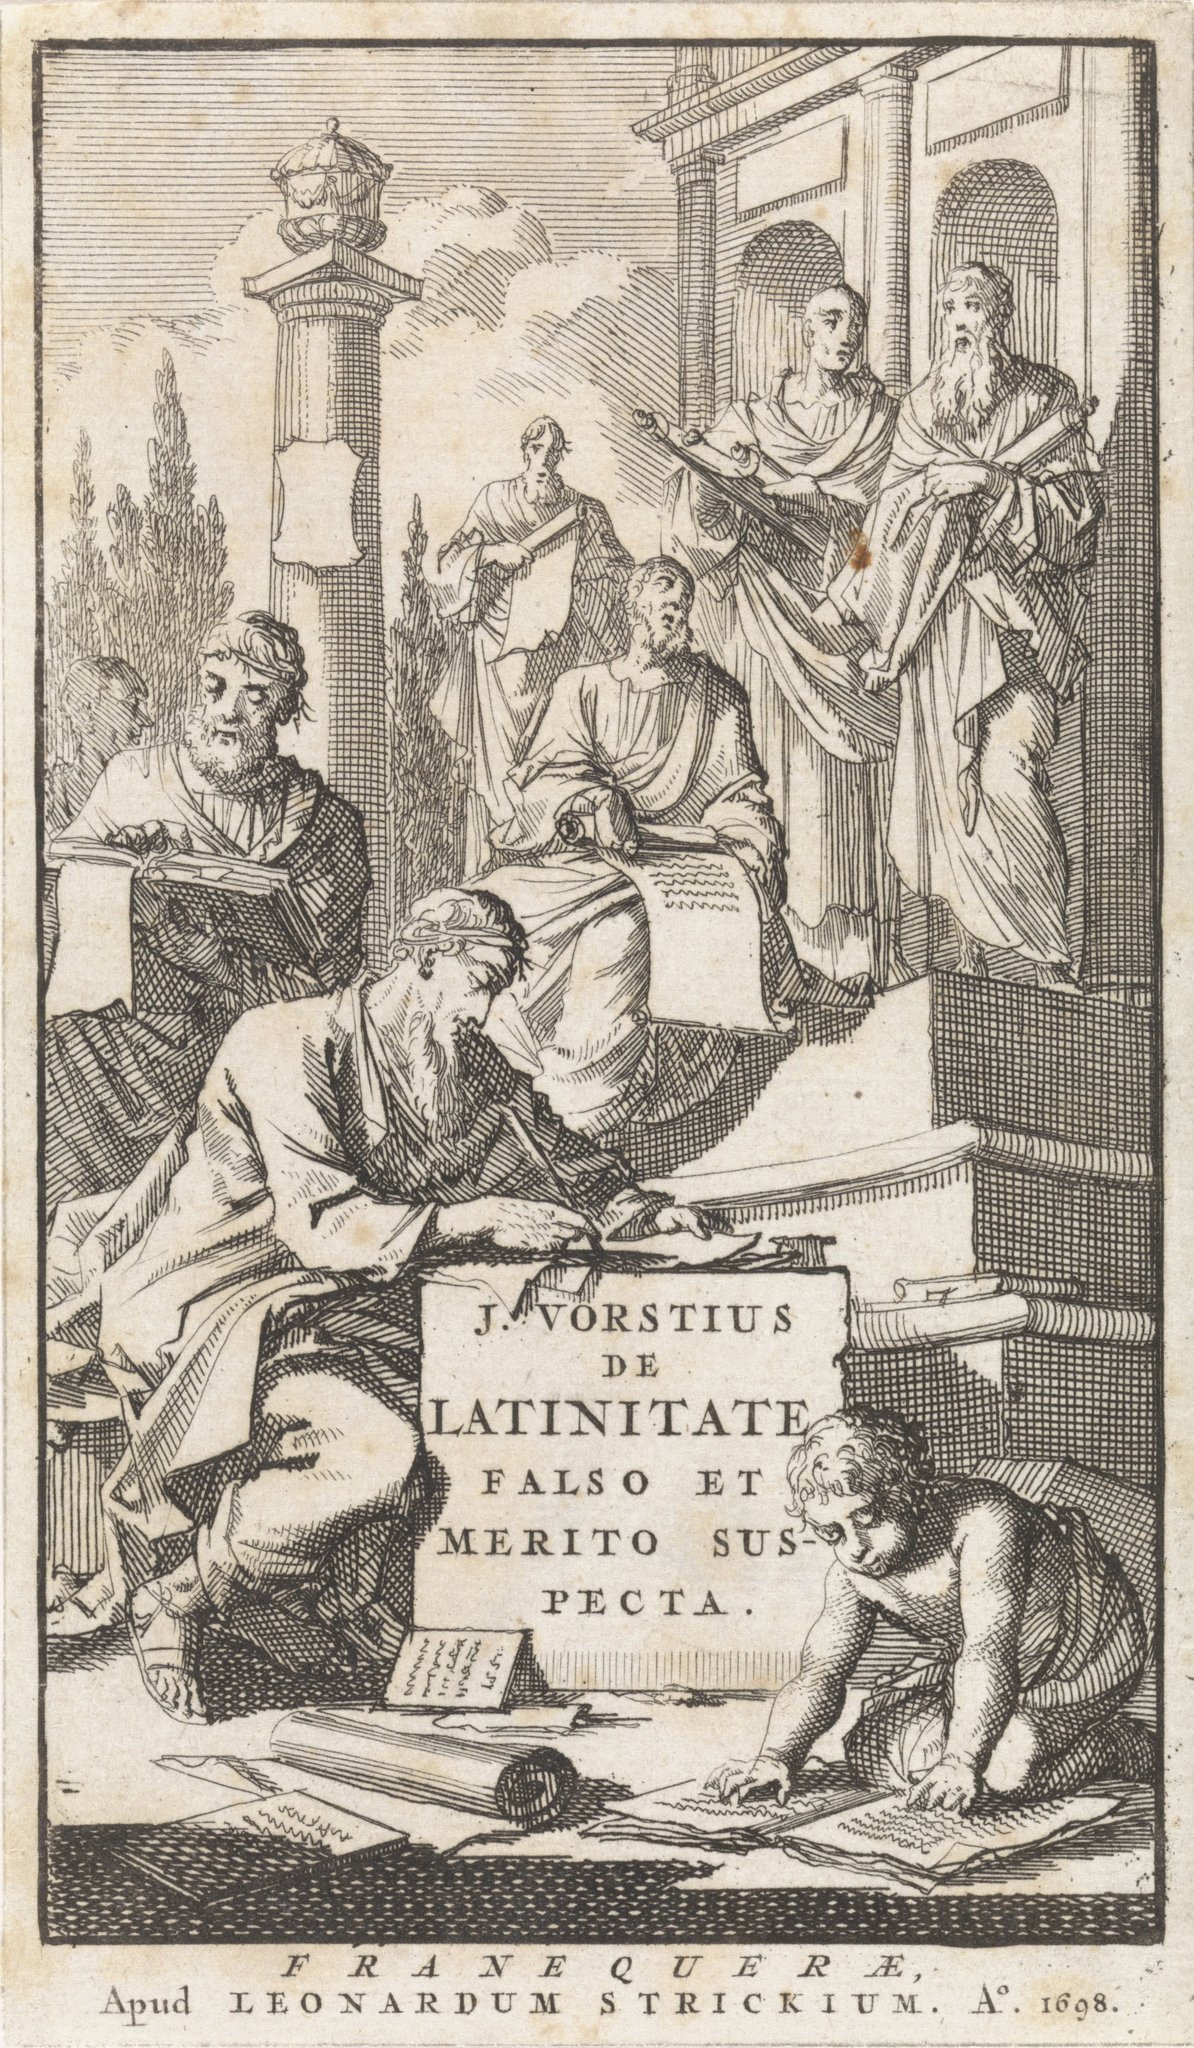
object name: print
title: Zes geleerden met rollen perkament op de trap van een tempel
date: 1698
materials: paper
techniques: etching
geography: franeker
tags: parchment, vellum (writing material), group of scholars or philosophers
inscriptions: collector's mark: Lugt 2228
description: Titelpagina voor: Vorstius, Johannes. De latinitate merito suspecta, deque vitiis sermonis Latini, quæ vulgo ferè non animadvertuntur, liber. Franeker: Leonardus Strick, 1698.